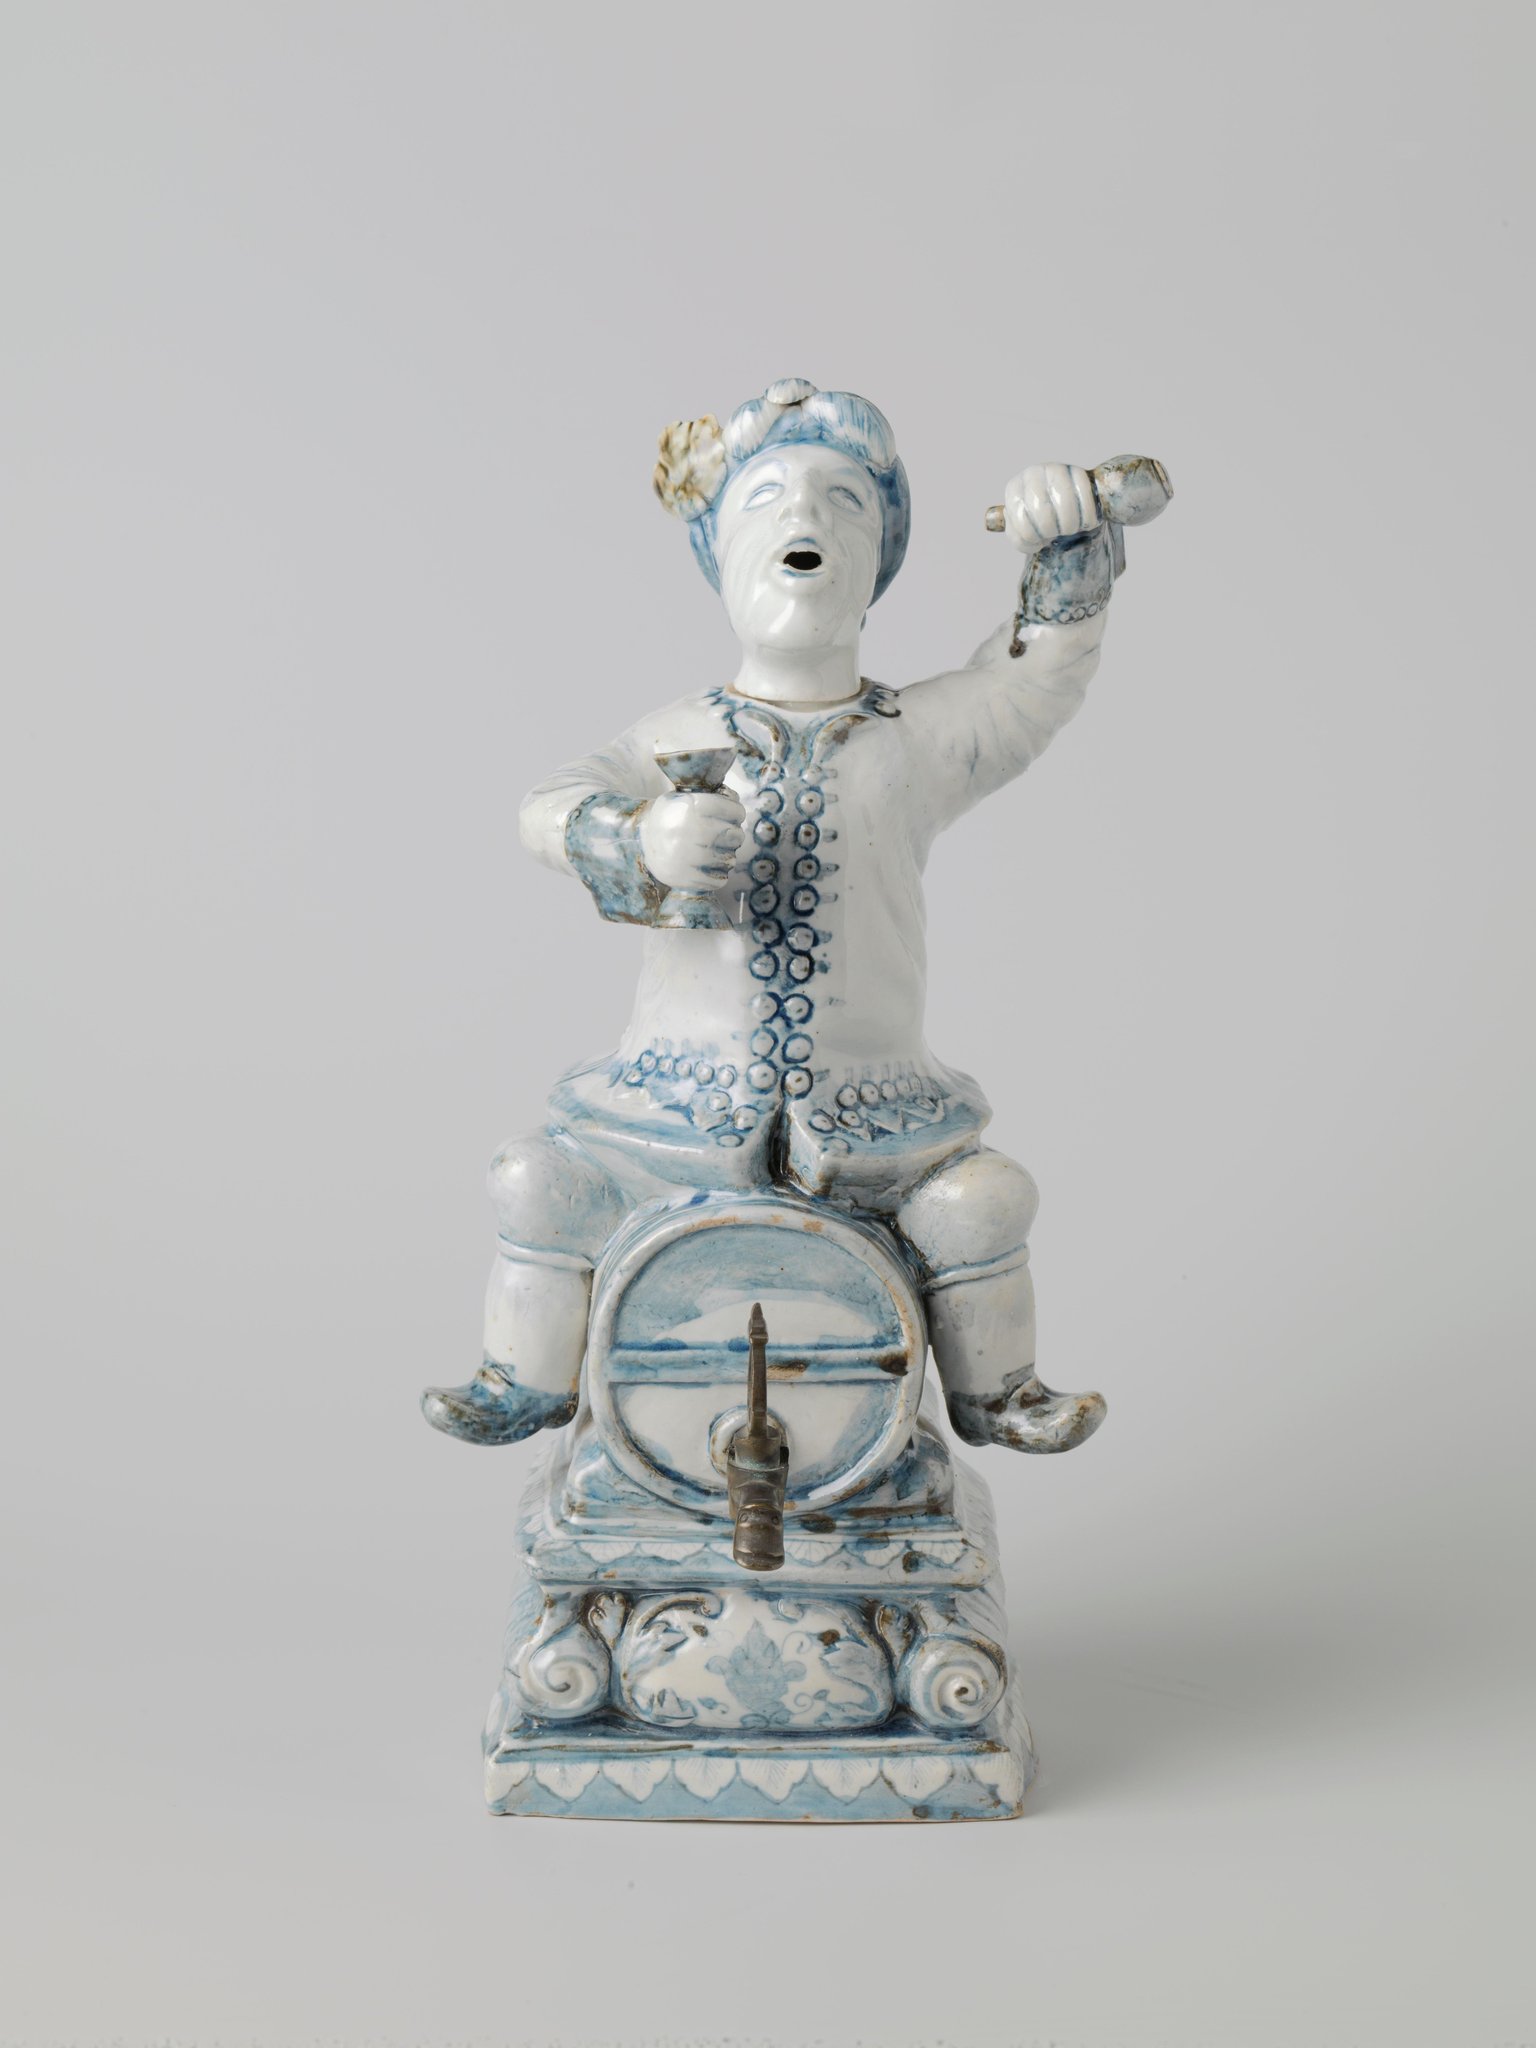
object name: figure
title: Gin Jug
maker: Anonymous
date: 1750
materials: cobalt, glaze, paint, porcelain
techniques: firing, forming, vitrification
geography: japan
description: Jeneverkruik in de vorm van een man zittende op een ton met glas en fles in de hand, blauw beschilderd. Uit de ton steekt een koperen kraantje. Het hoofd is los en dient als stop.